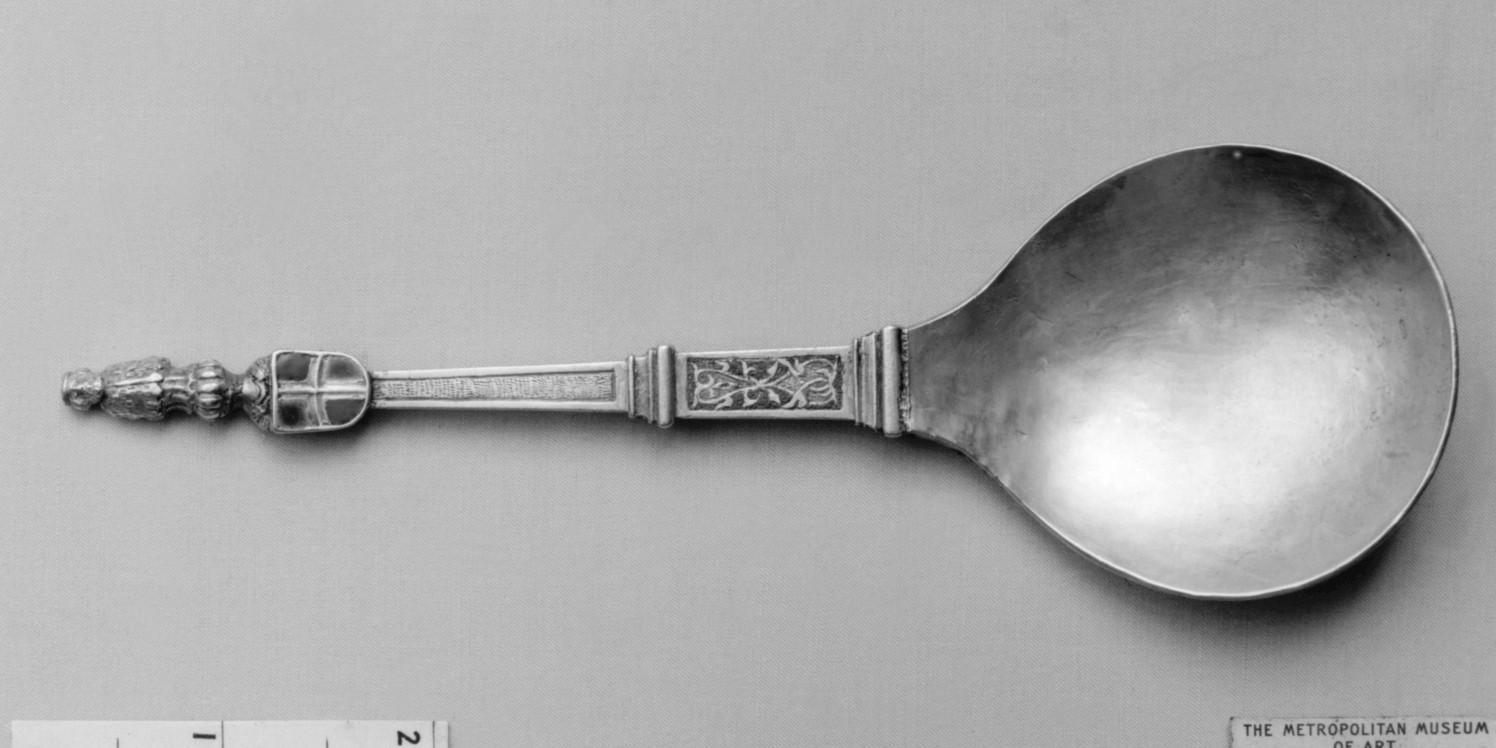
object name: spoon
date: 1501-1600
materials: silver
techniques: enamel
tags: shields